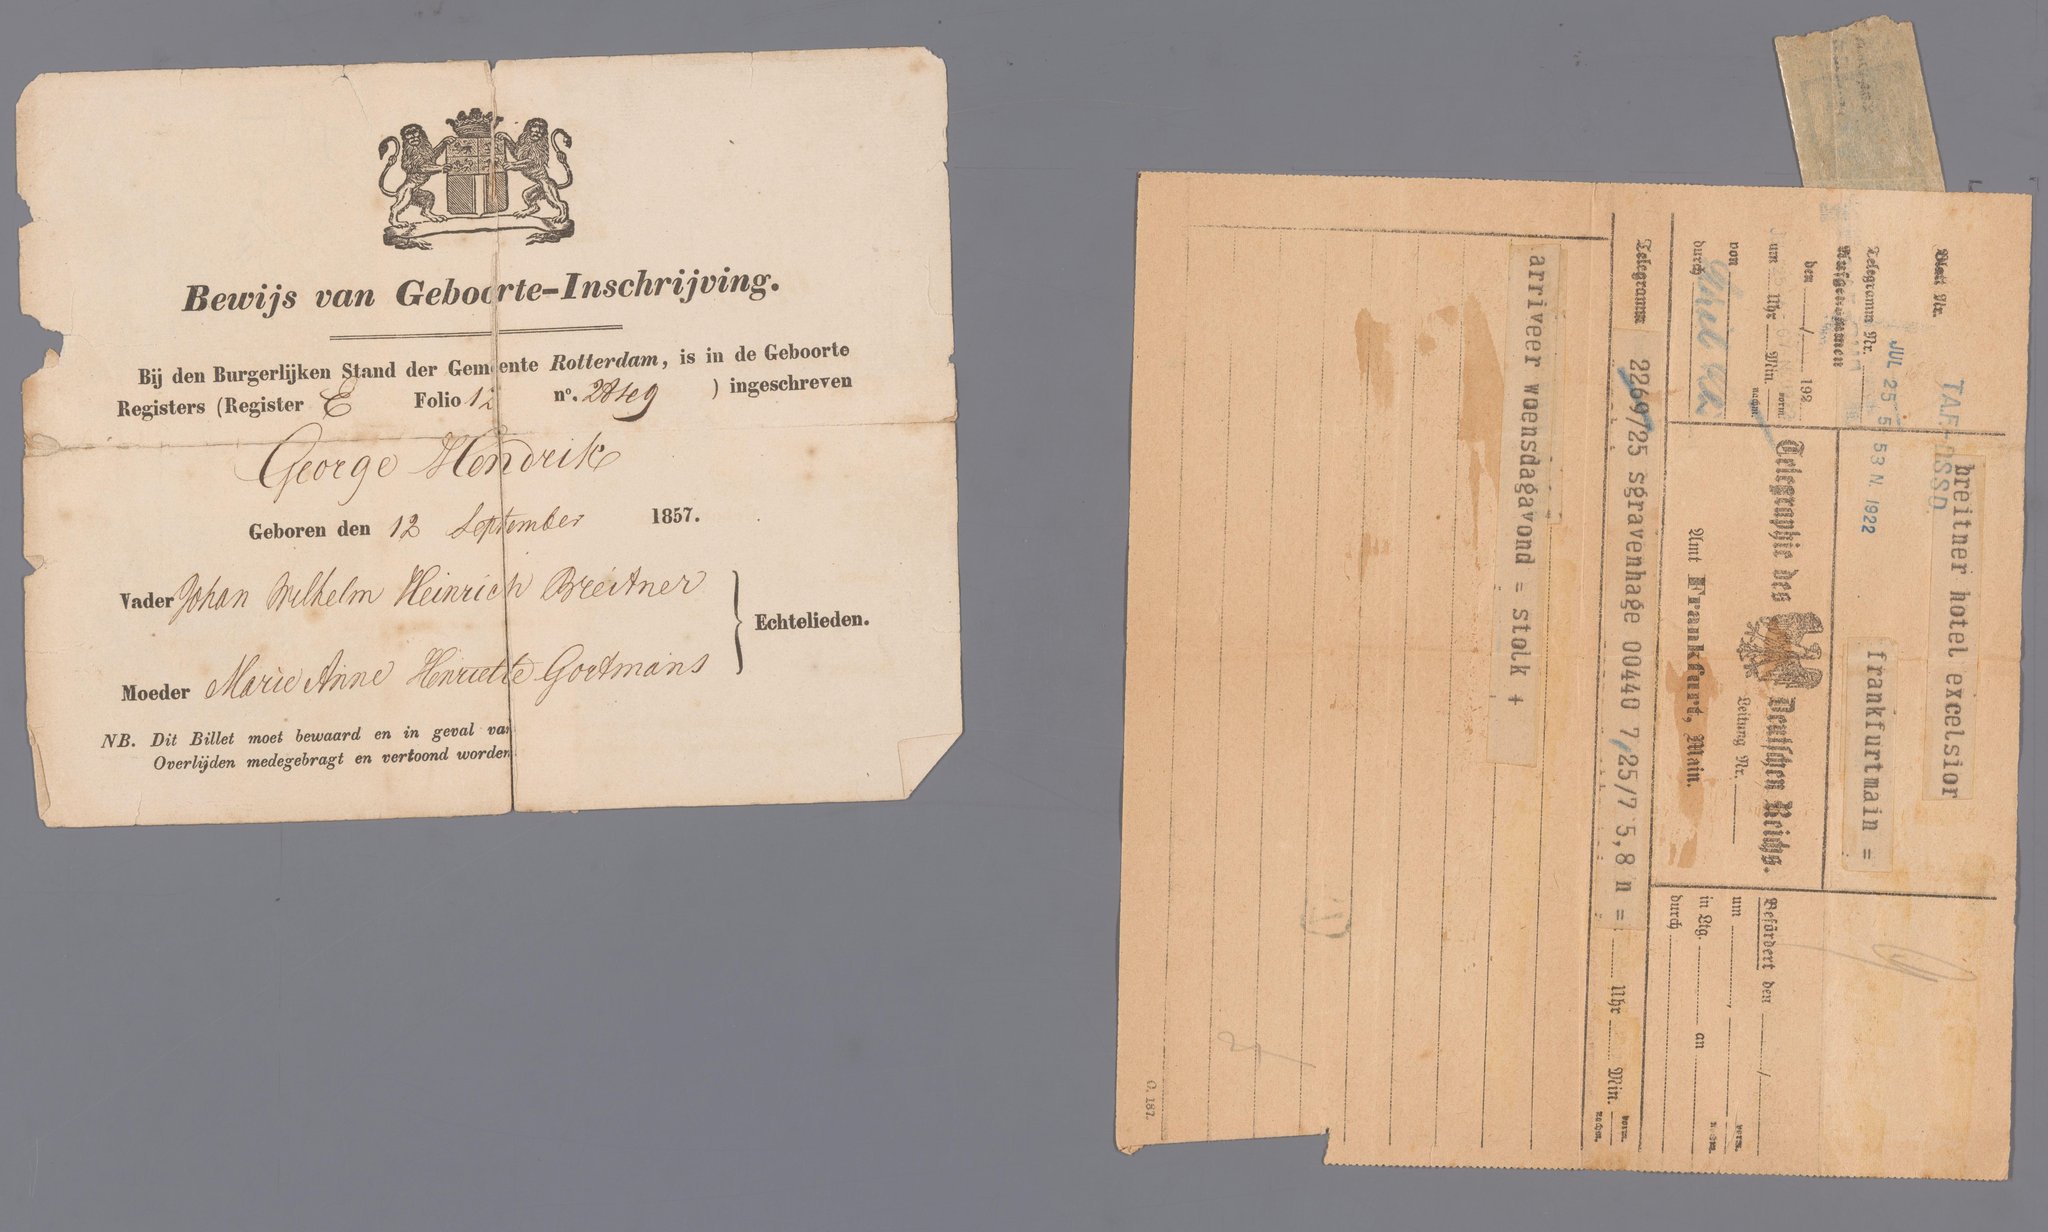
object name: document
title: Geboortebewijs van George Hendrik Breitner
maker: Anonymous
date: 1857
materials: paper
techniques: printing, writing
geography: netherlands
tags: rotterdam, amsterdam, painter, print maker, draughtsman, george hendrik breitner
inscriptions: date